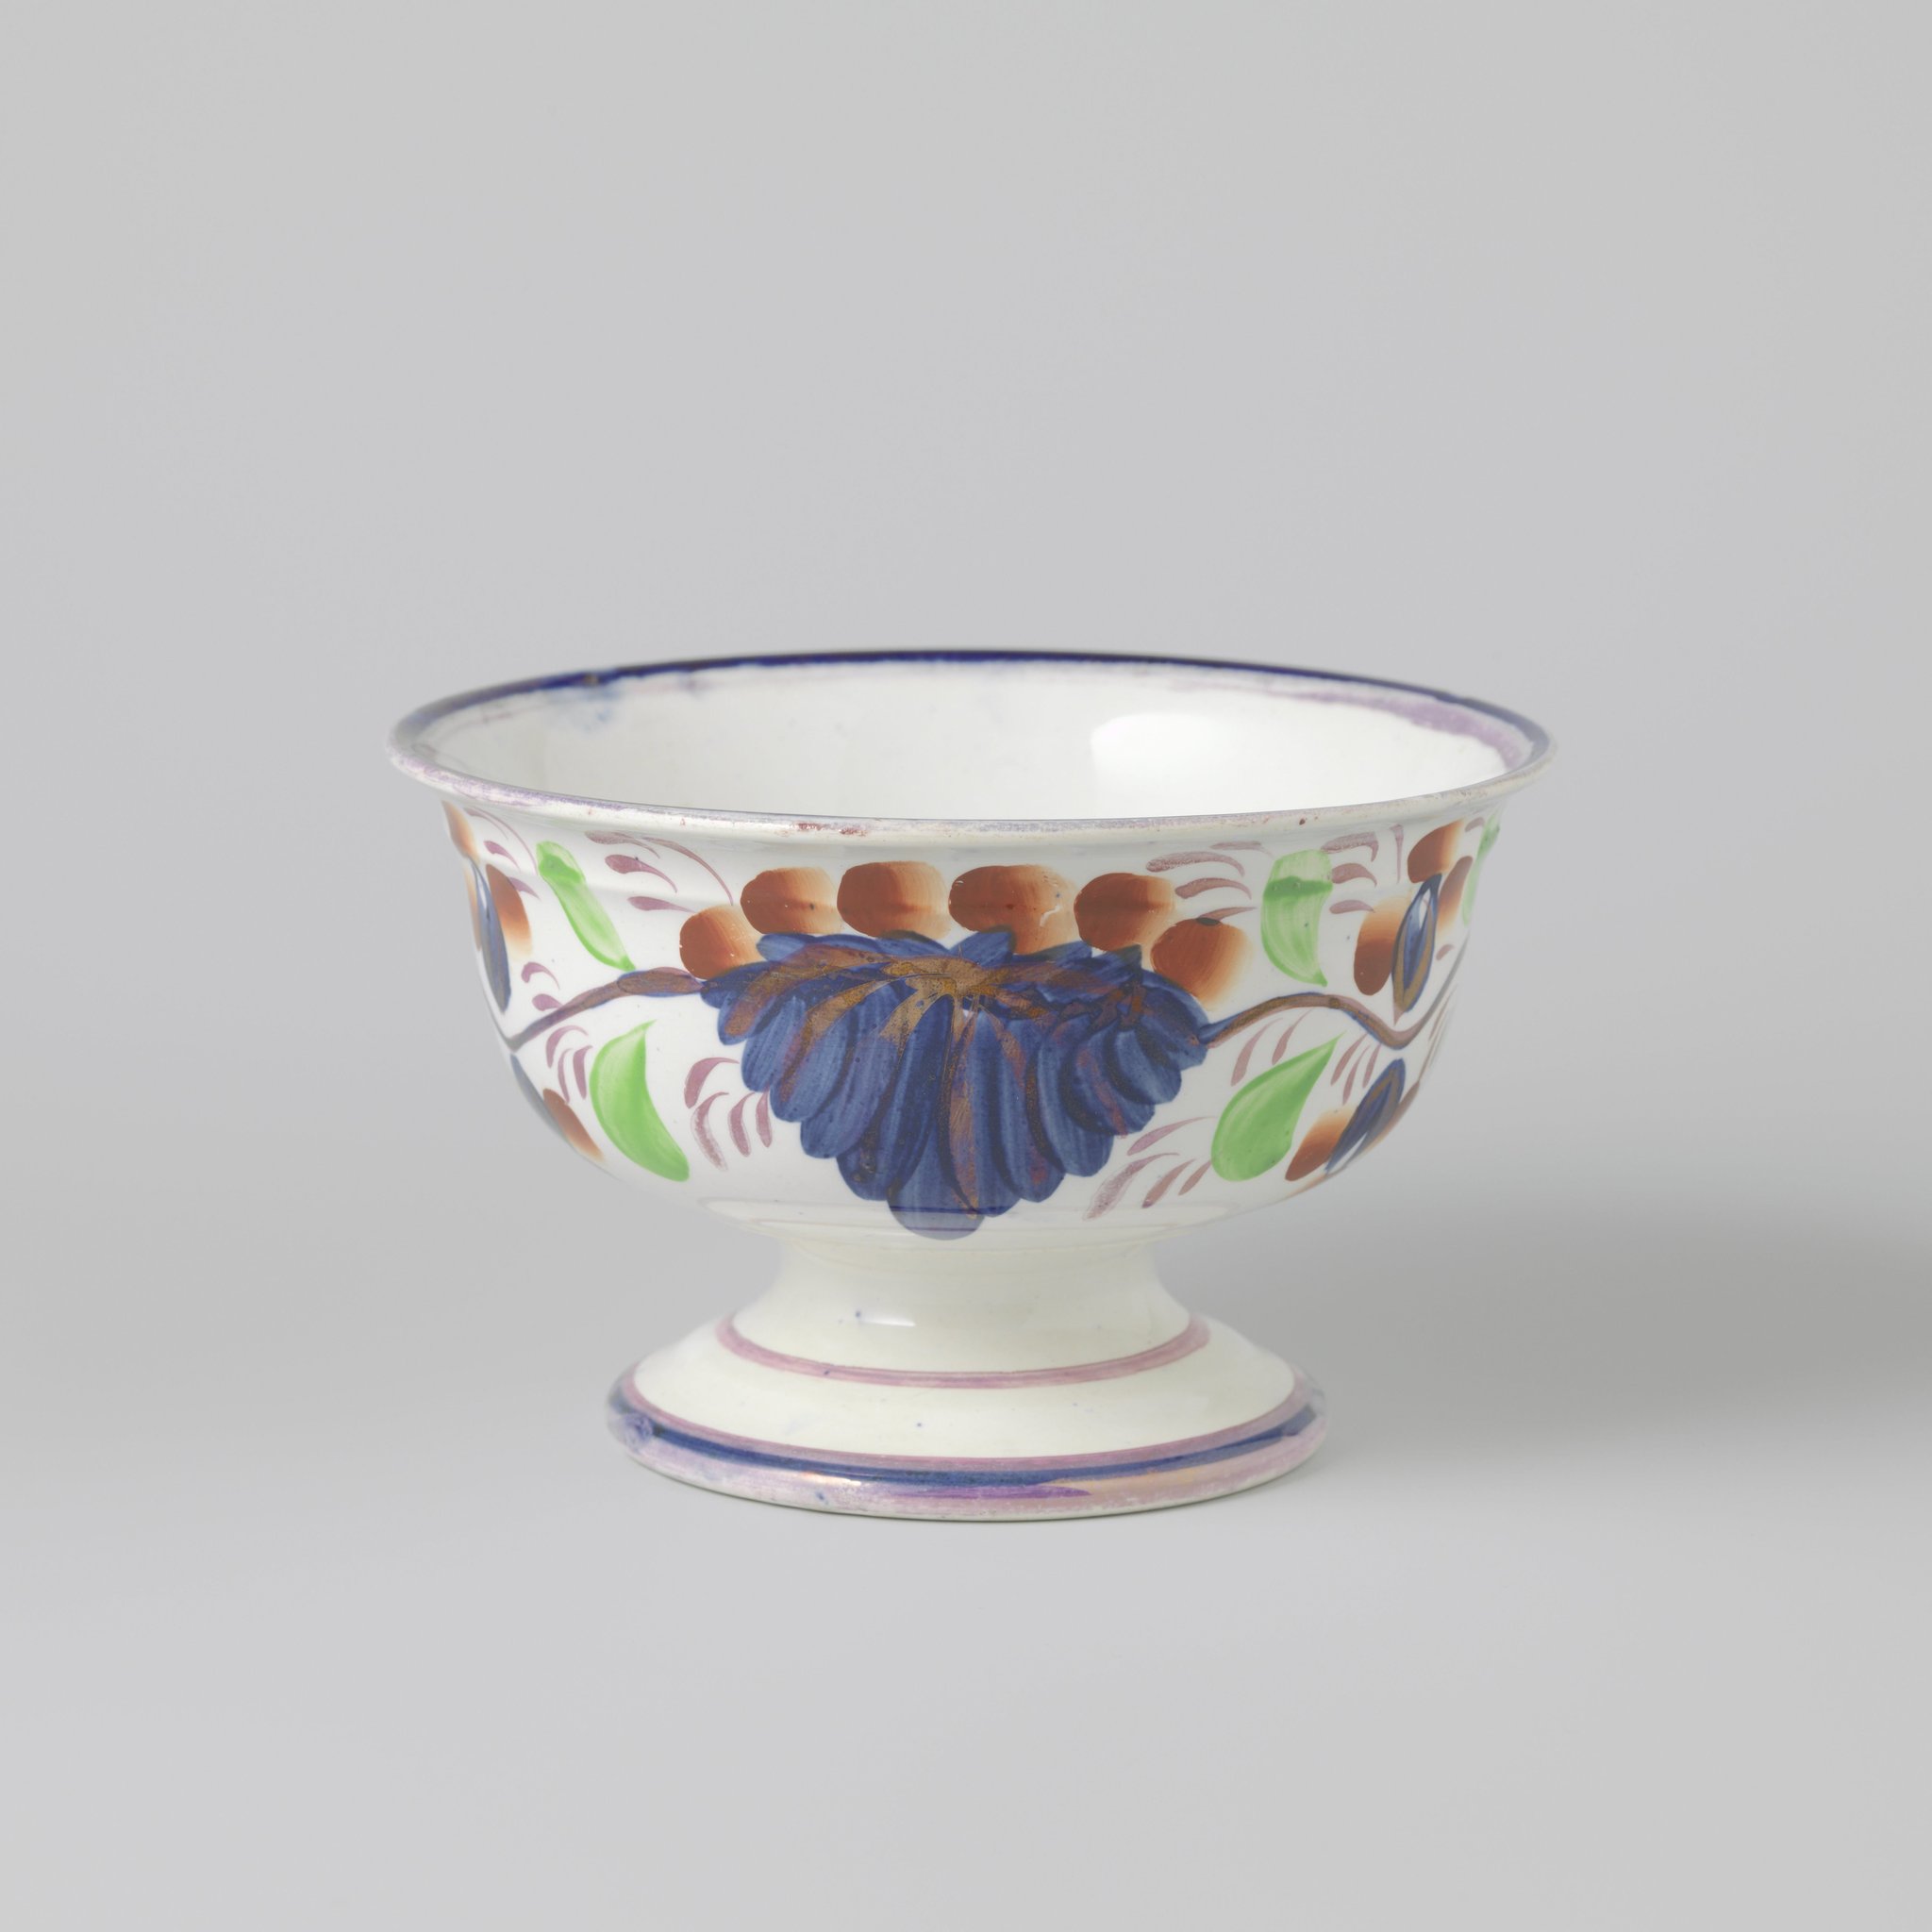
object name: bowl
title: kastkom met boerenbontdecor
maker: petrus regout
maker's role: plateelbakker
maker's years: 1801-1879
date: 1801-1879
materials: earthenware, glaze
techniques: painted, vitrification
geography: maastricht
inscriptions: check stamp: ‘P. REGOUT // MAASTRICHT’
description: Kastkom van aardewerk, beschilderd met boerenbontdecor in blauw, groen, oranje-rood en lilaluster. De bovenrand en de voetrand met een bies in blauw en lilaluster.